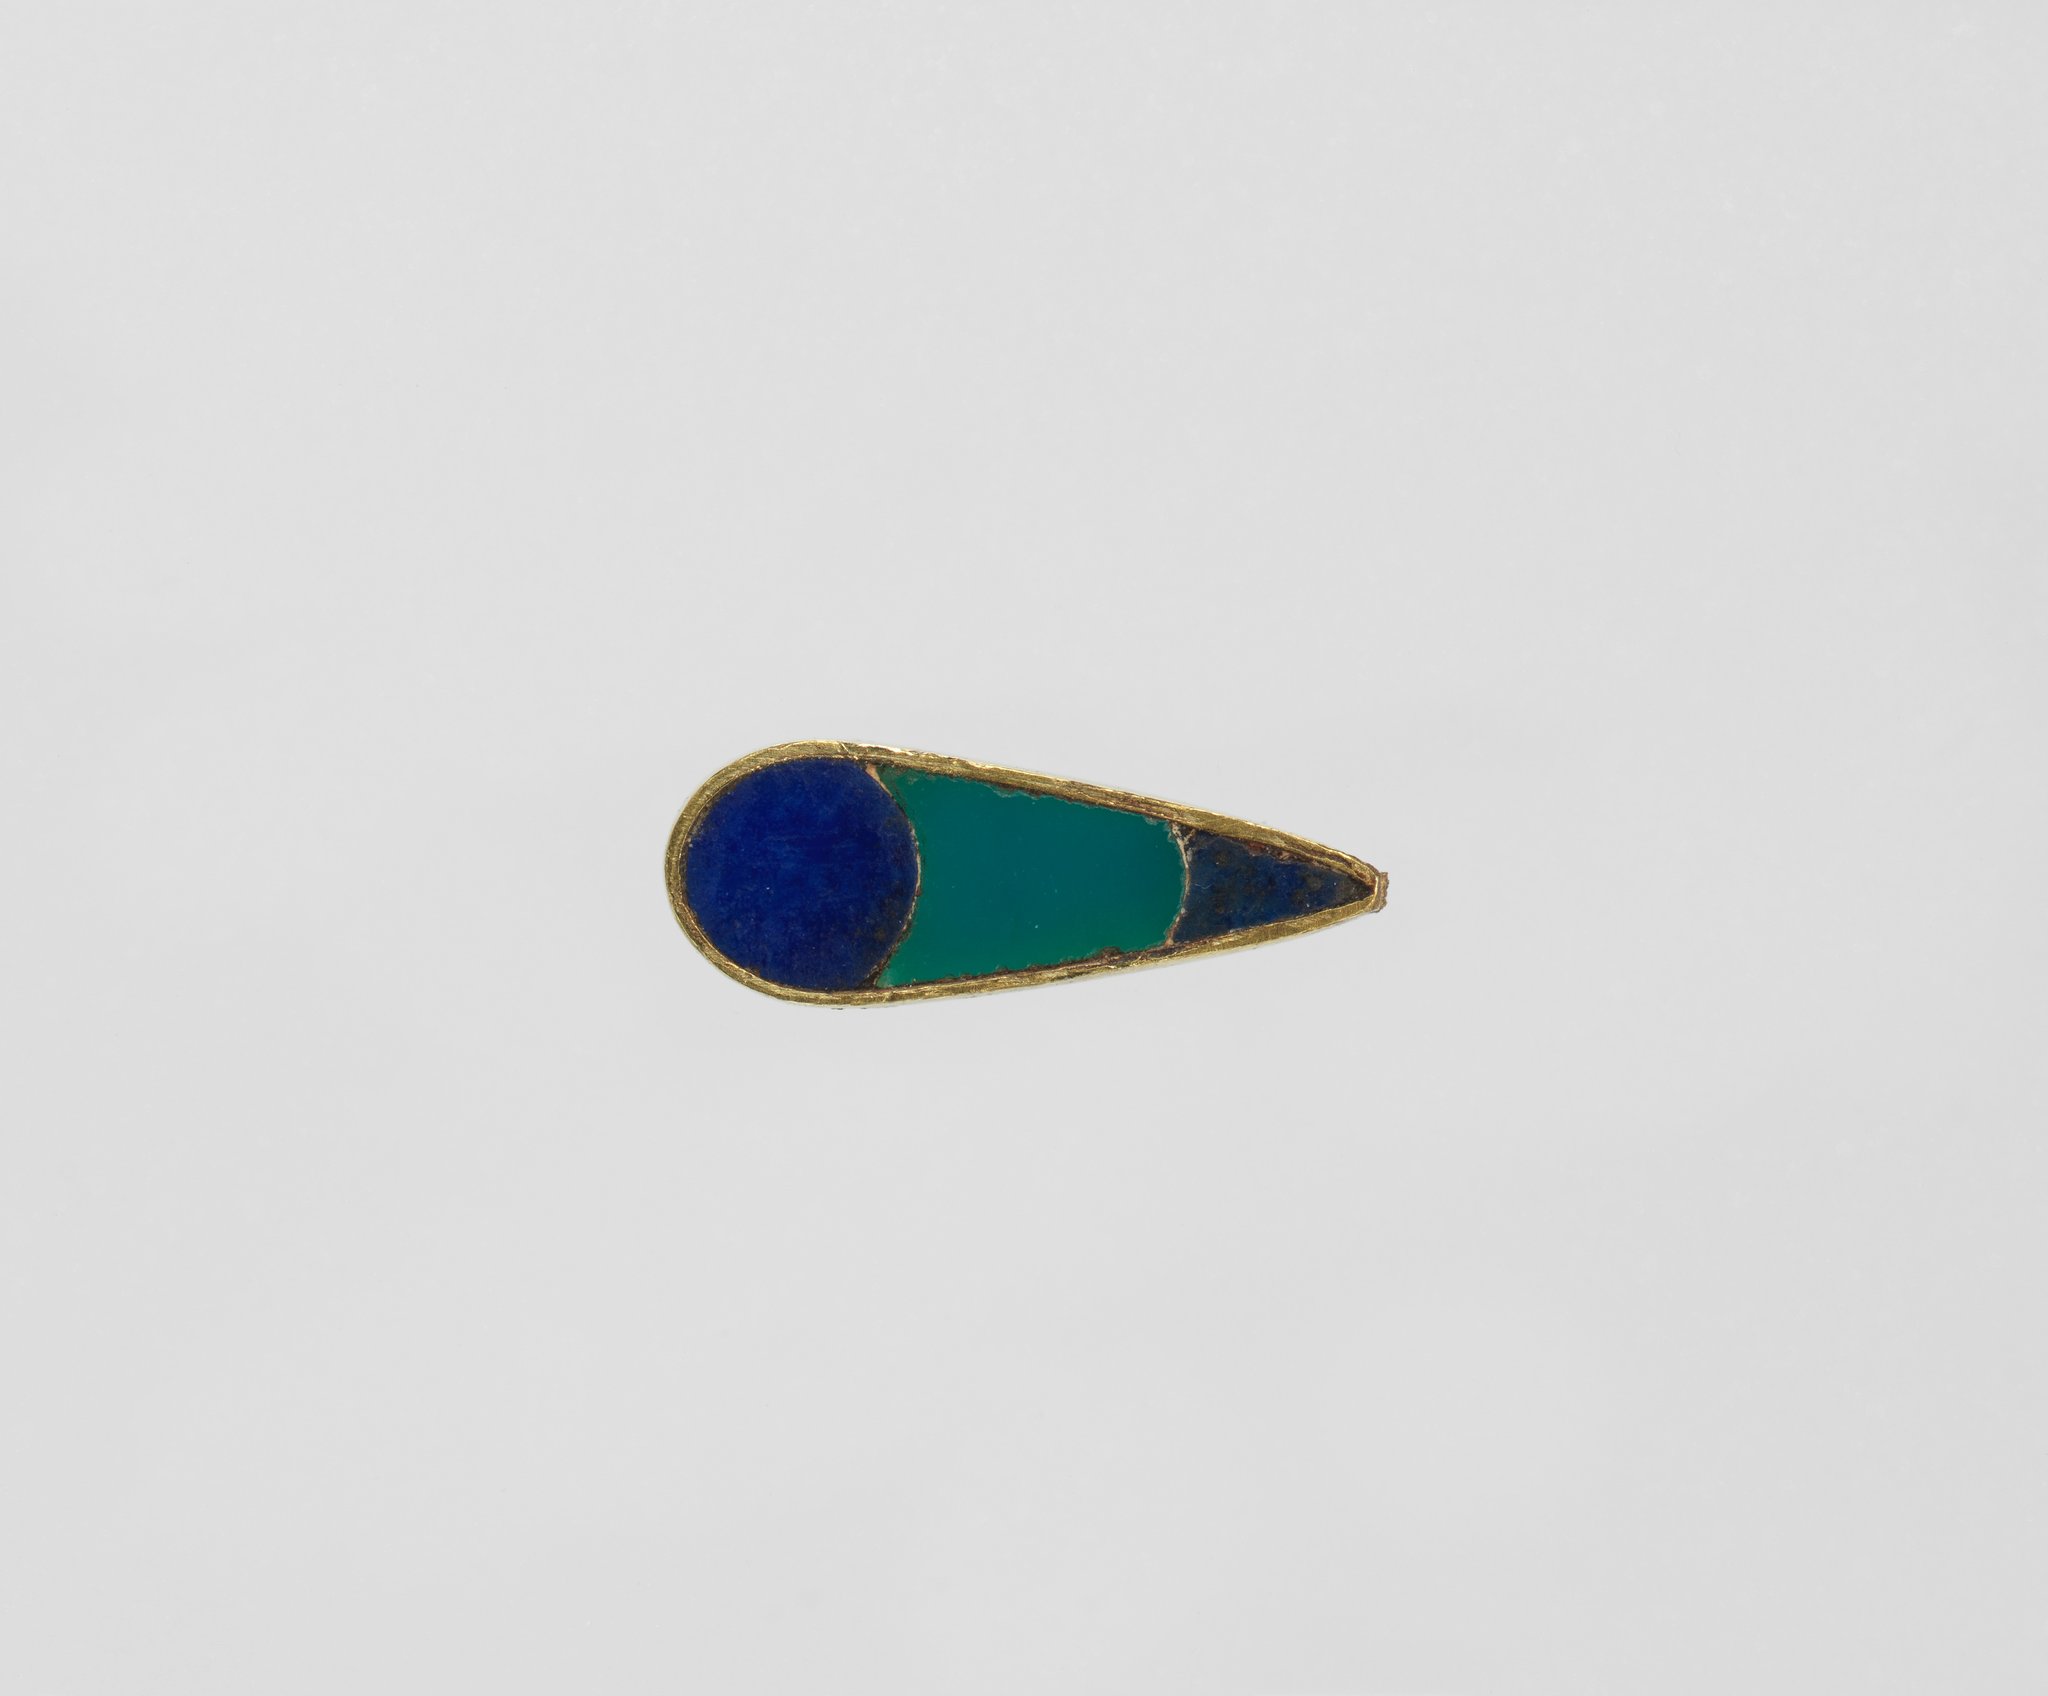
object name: bead, drop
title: Drop pendant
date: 1878-1840 BCE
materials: gold, lapis lazuli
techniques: inlay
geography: memphite region